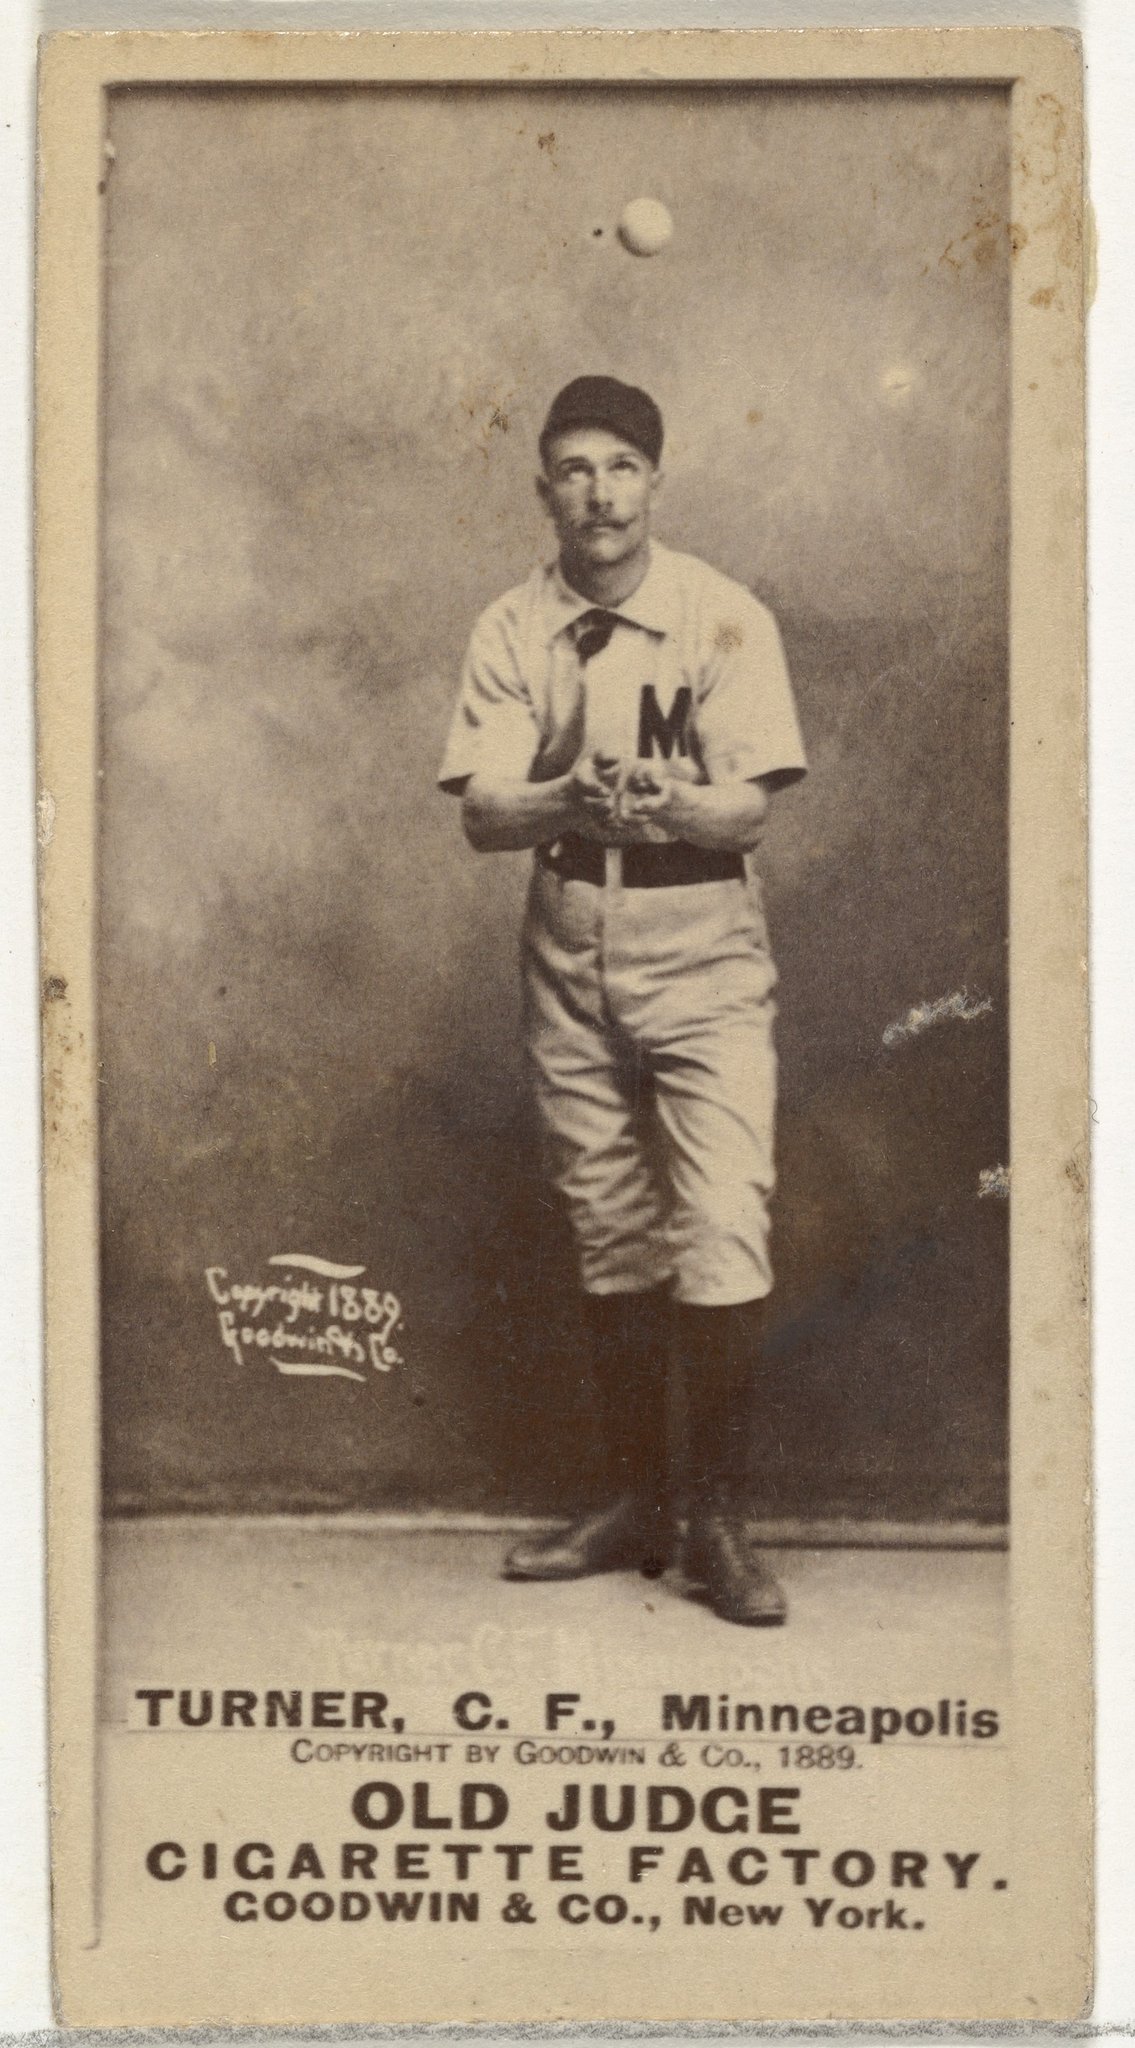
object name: baseball card, photograph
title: Thomas Turner, Center Field, Minneapolis, from the Old Judge series (N172) for Old Judge Cigarettes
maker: goodwin & company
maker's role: publisher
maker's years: 1850-1950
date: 1889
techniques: albumen silver print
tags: men,portraits,baseball,athletes